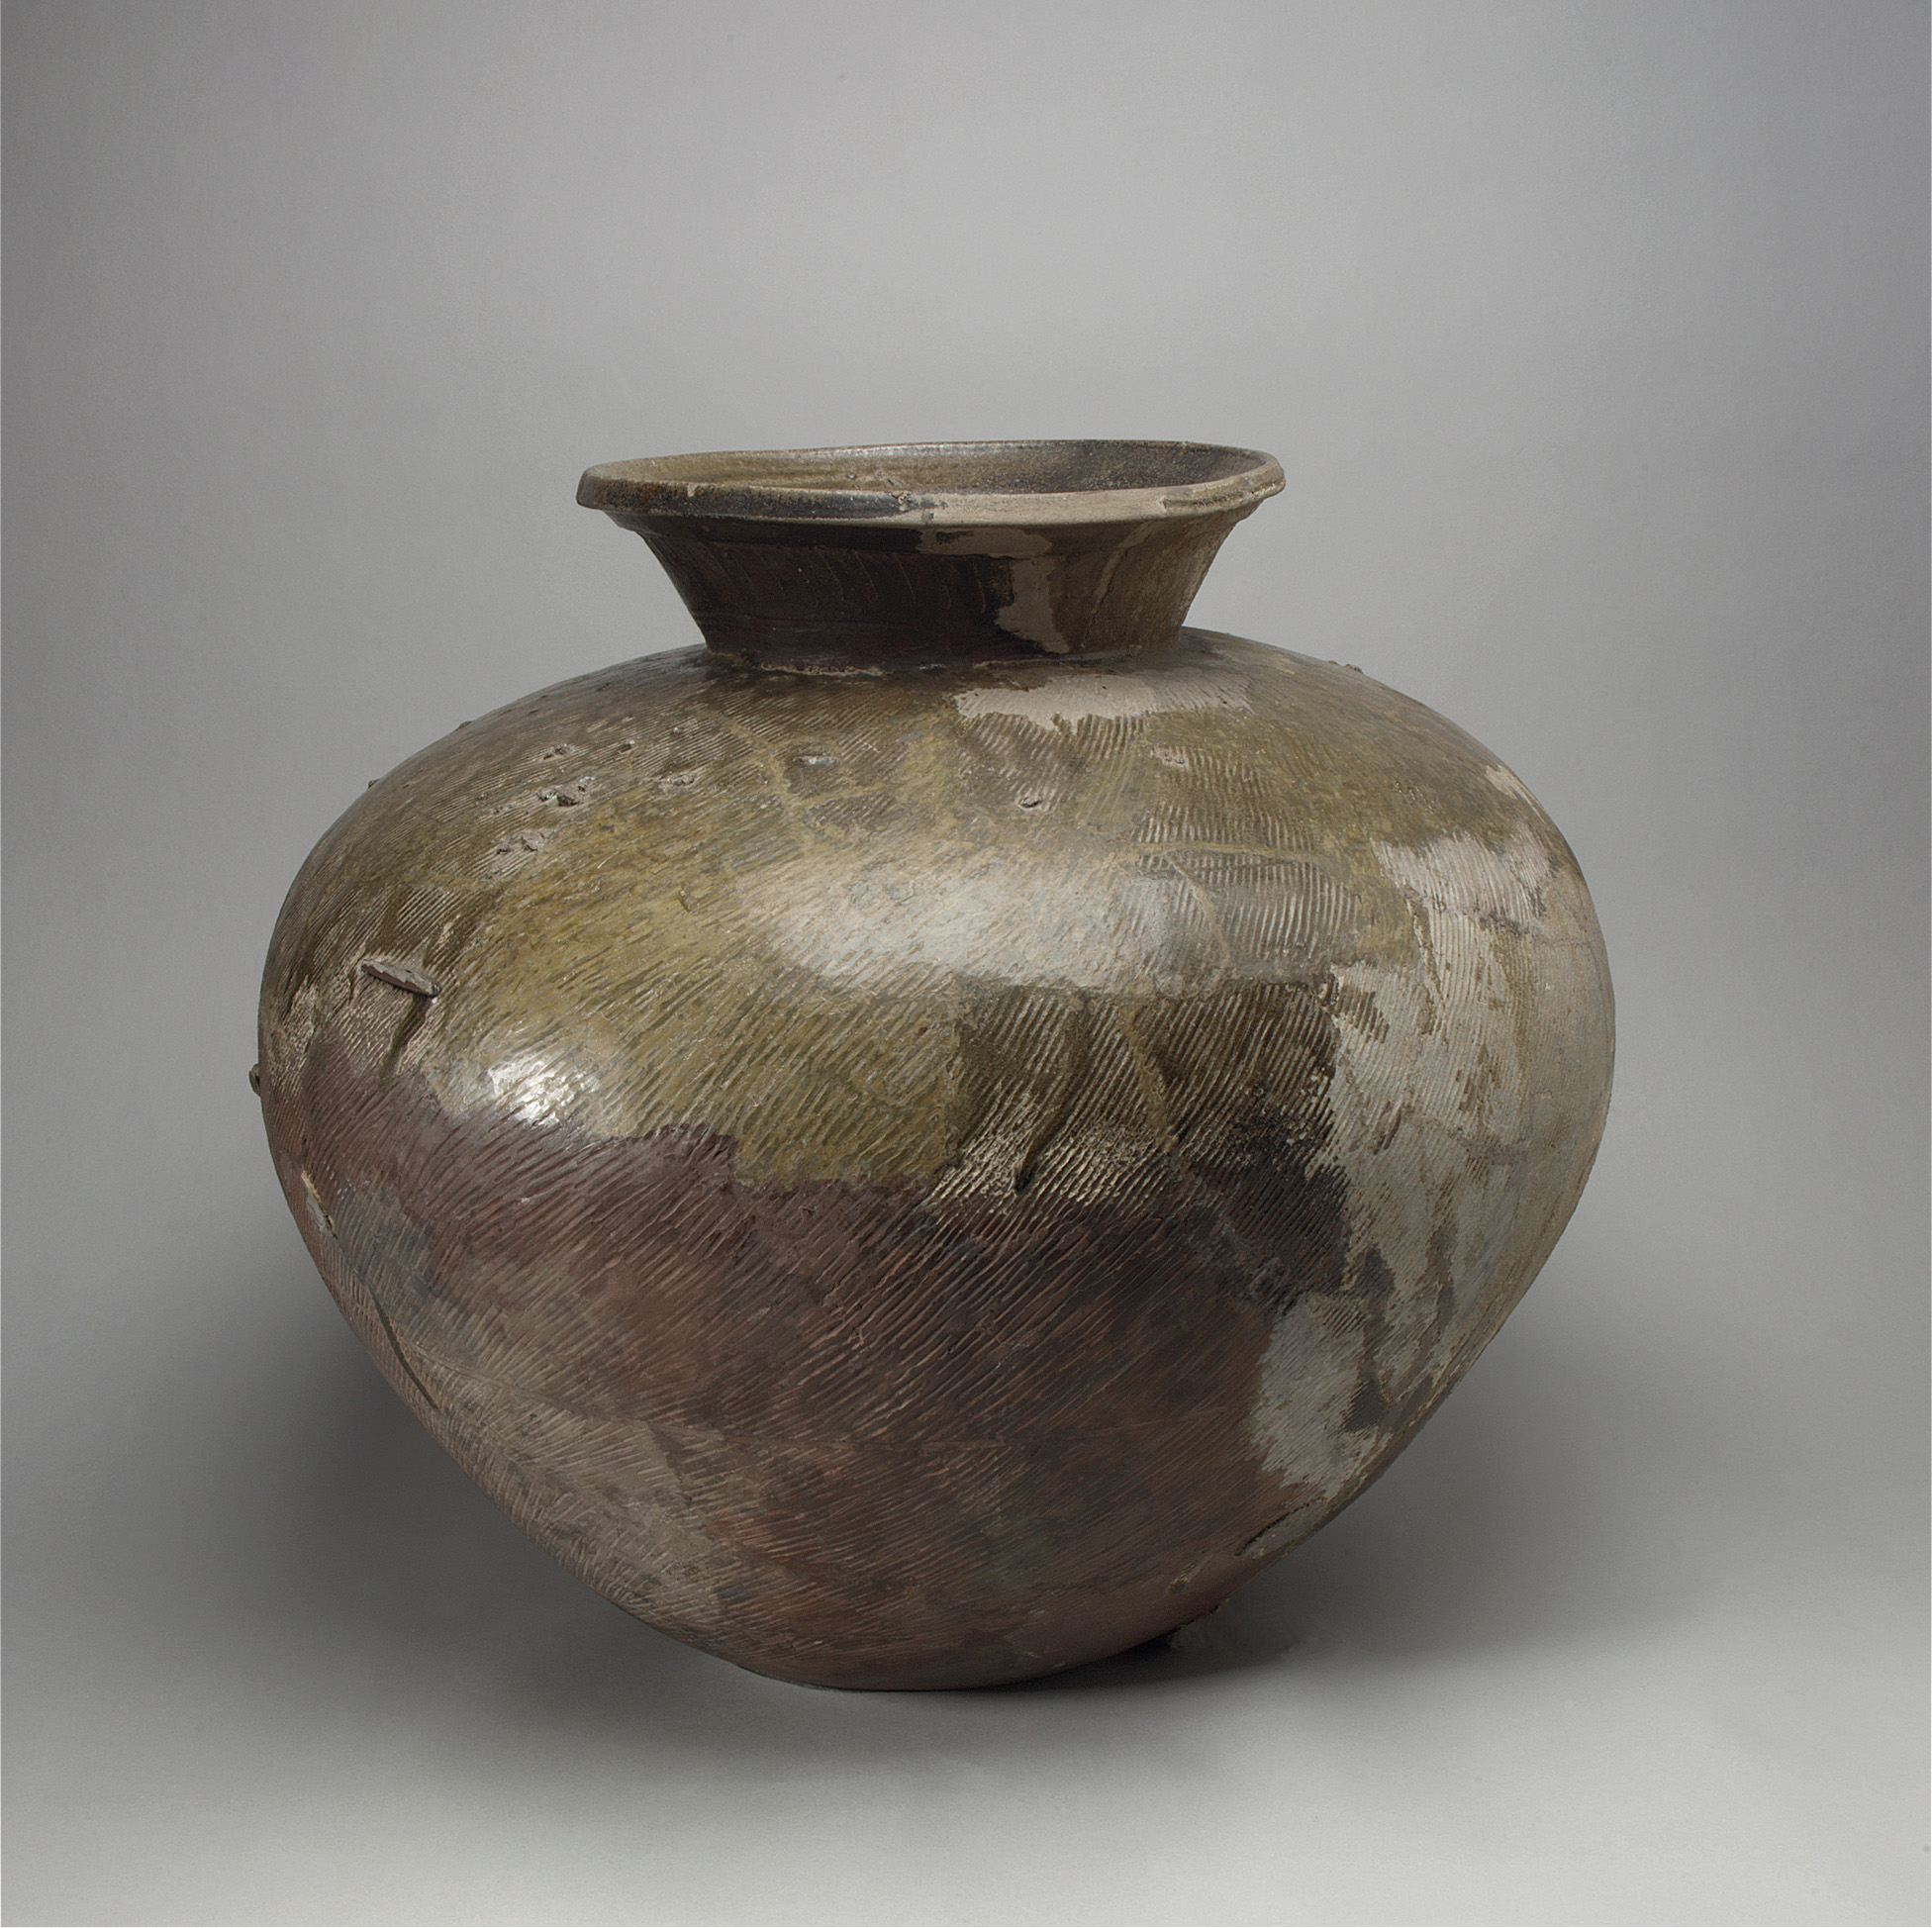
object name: jar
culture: japanese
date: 501-700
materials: wood, glaze, stoneware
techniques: incising